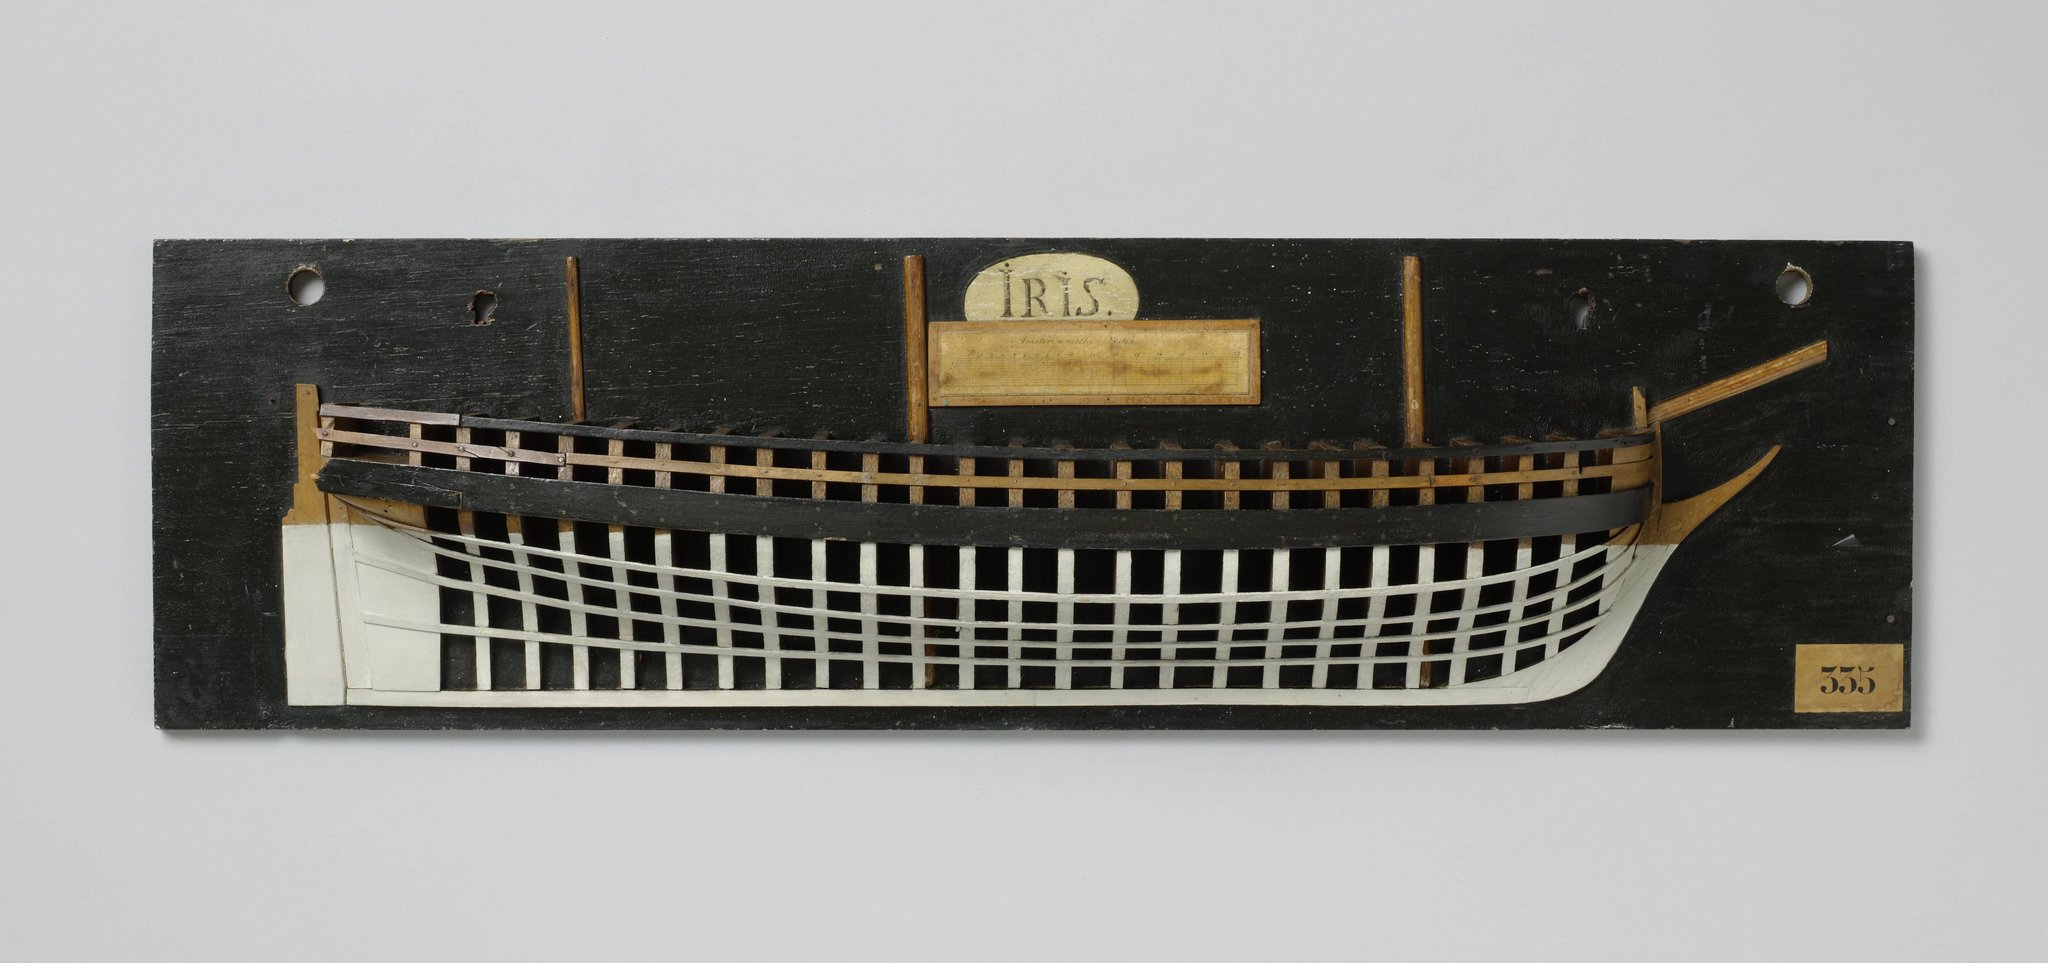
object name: half model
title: Half Model of an 18-Gun Sloop of War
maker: Anonymous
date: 1802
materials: wood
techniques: polychromy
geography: amsterdam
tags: amsterdam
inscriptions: inscription, top centre, on an oval white label: ‘IRIS.’, label, bottom right: ‘335’ former inventory label, scale, top centre: paper scale in Amsterdam feet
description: Gepolychromeerd mallenmodel (stuurboord) van een driemaster. Opvallend is het grote aantal spantmallen. Geen geschutpoorten of dekken aangegeven. Gewrongen spiegel, geen details van het wulf of het hek, geen zijgalerij; recht roer met vierkante roerkoning. Zeeg voor en achter iets oplopend, één berghout en één reehout. Gepiekt rondspant. Schaal 1:55 (schaal op model).